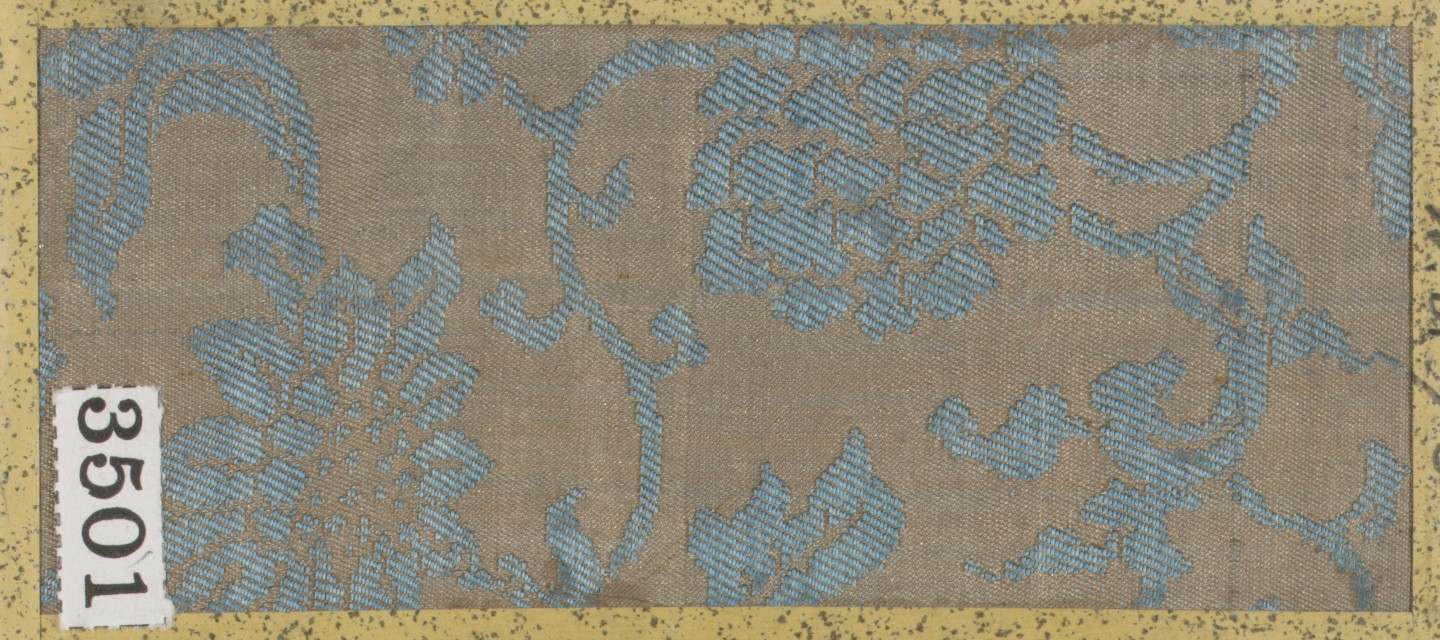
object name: sample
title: Textile Sample from Sample Book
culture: japanese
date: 1801-1900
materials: silk